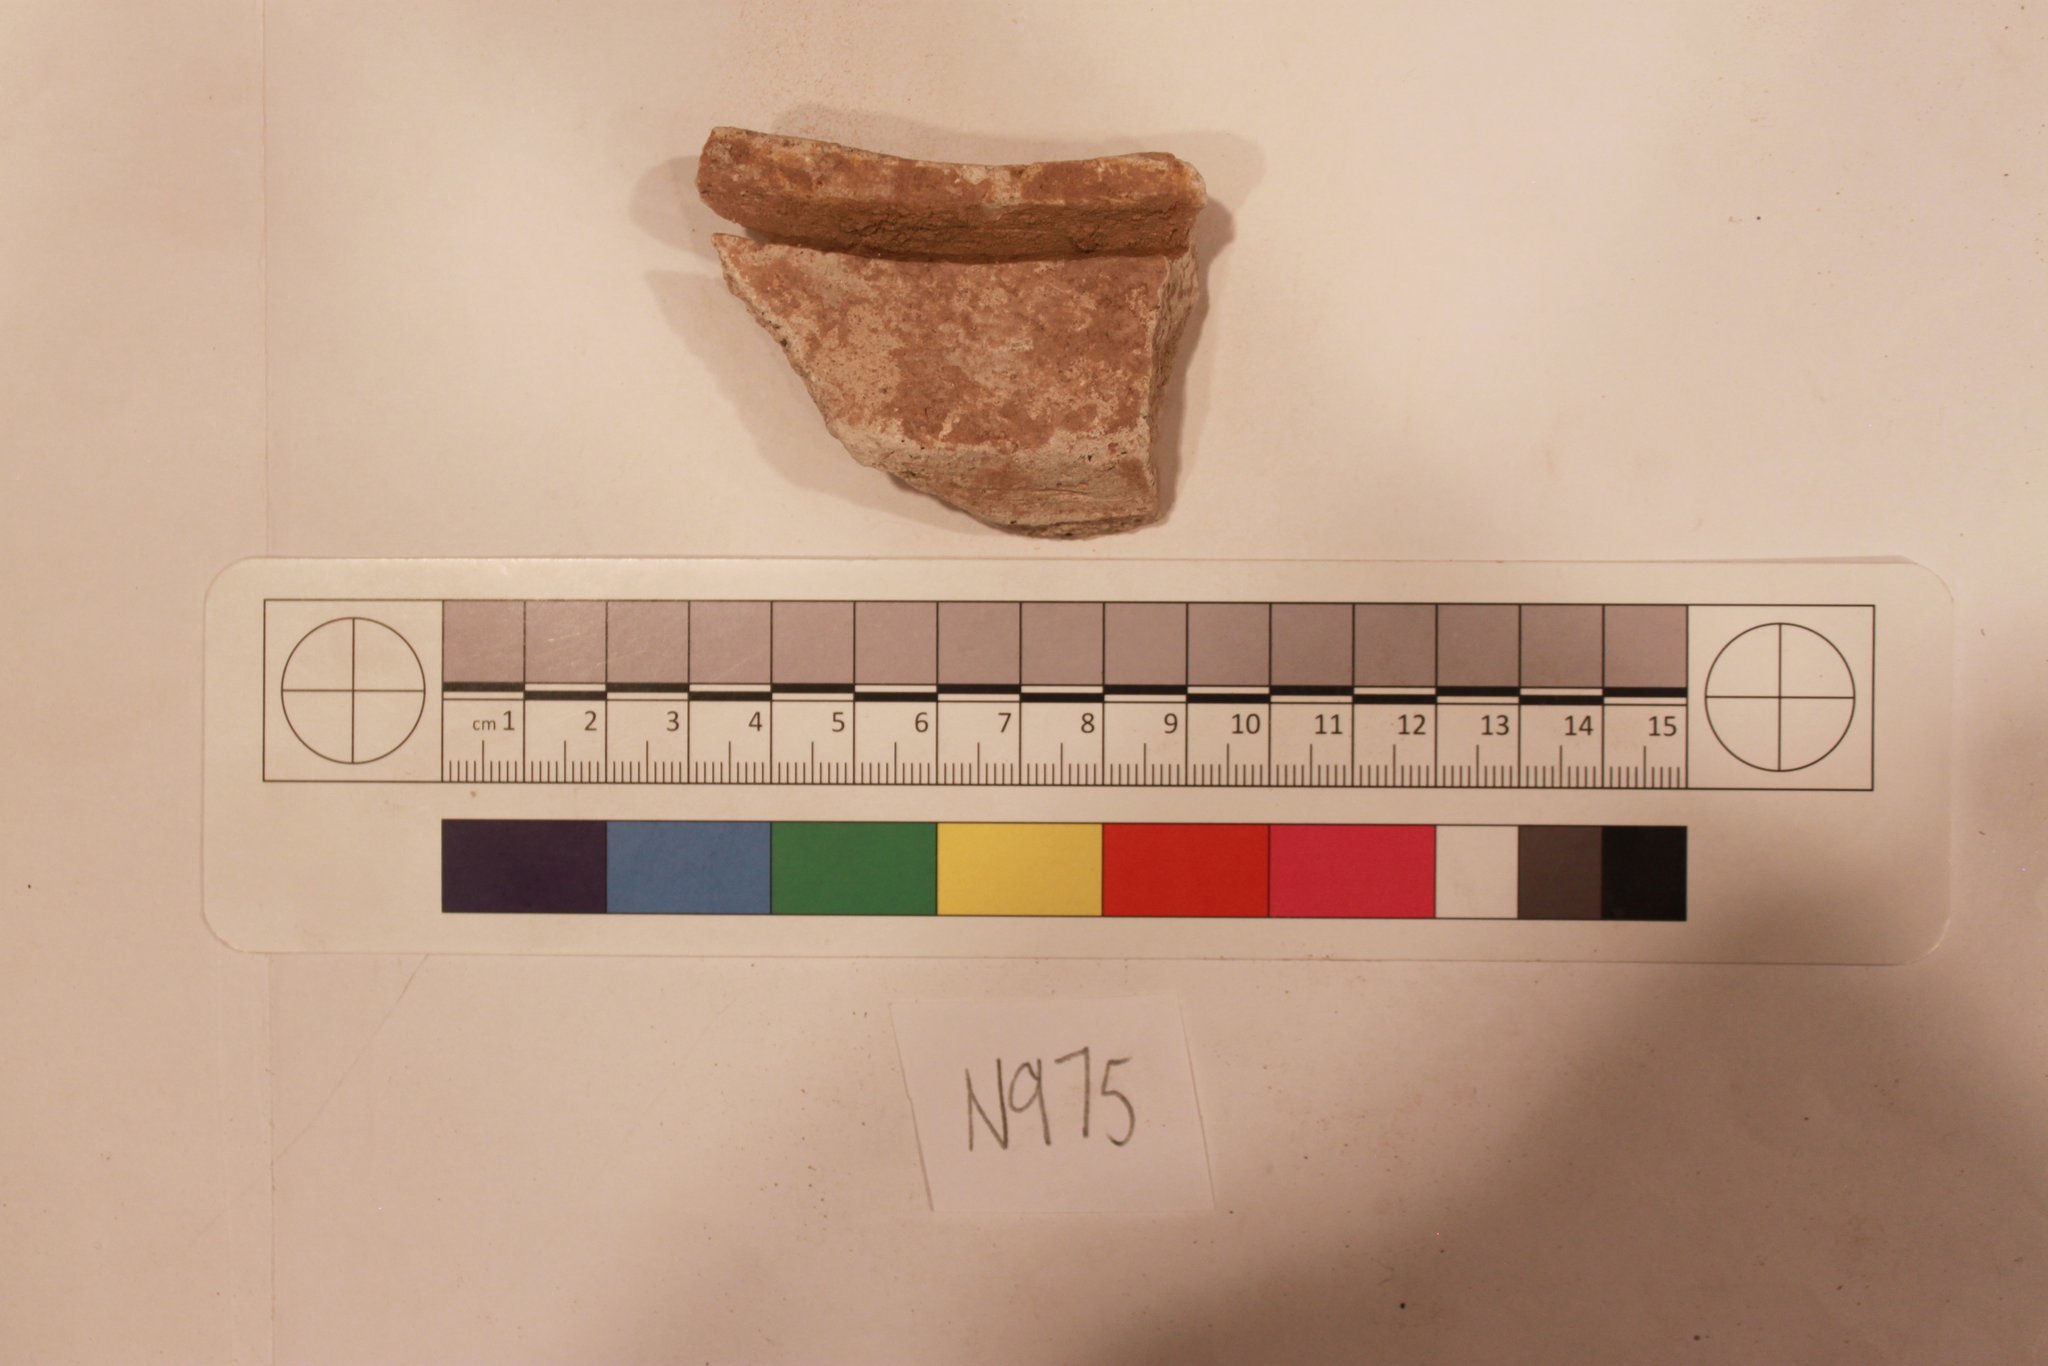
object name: fragment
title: Stucco Fragment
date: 701-1200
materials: plaster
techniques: carving, painting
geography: iran